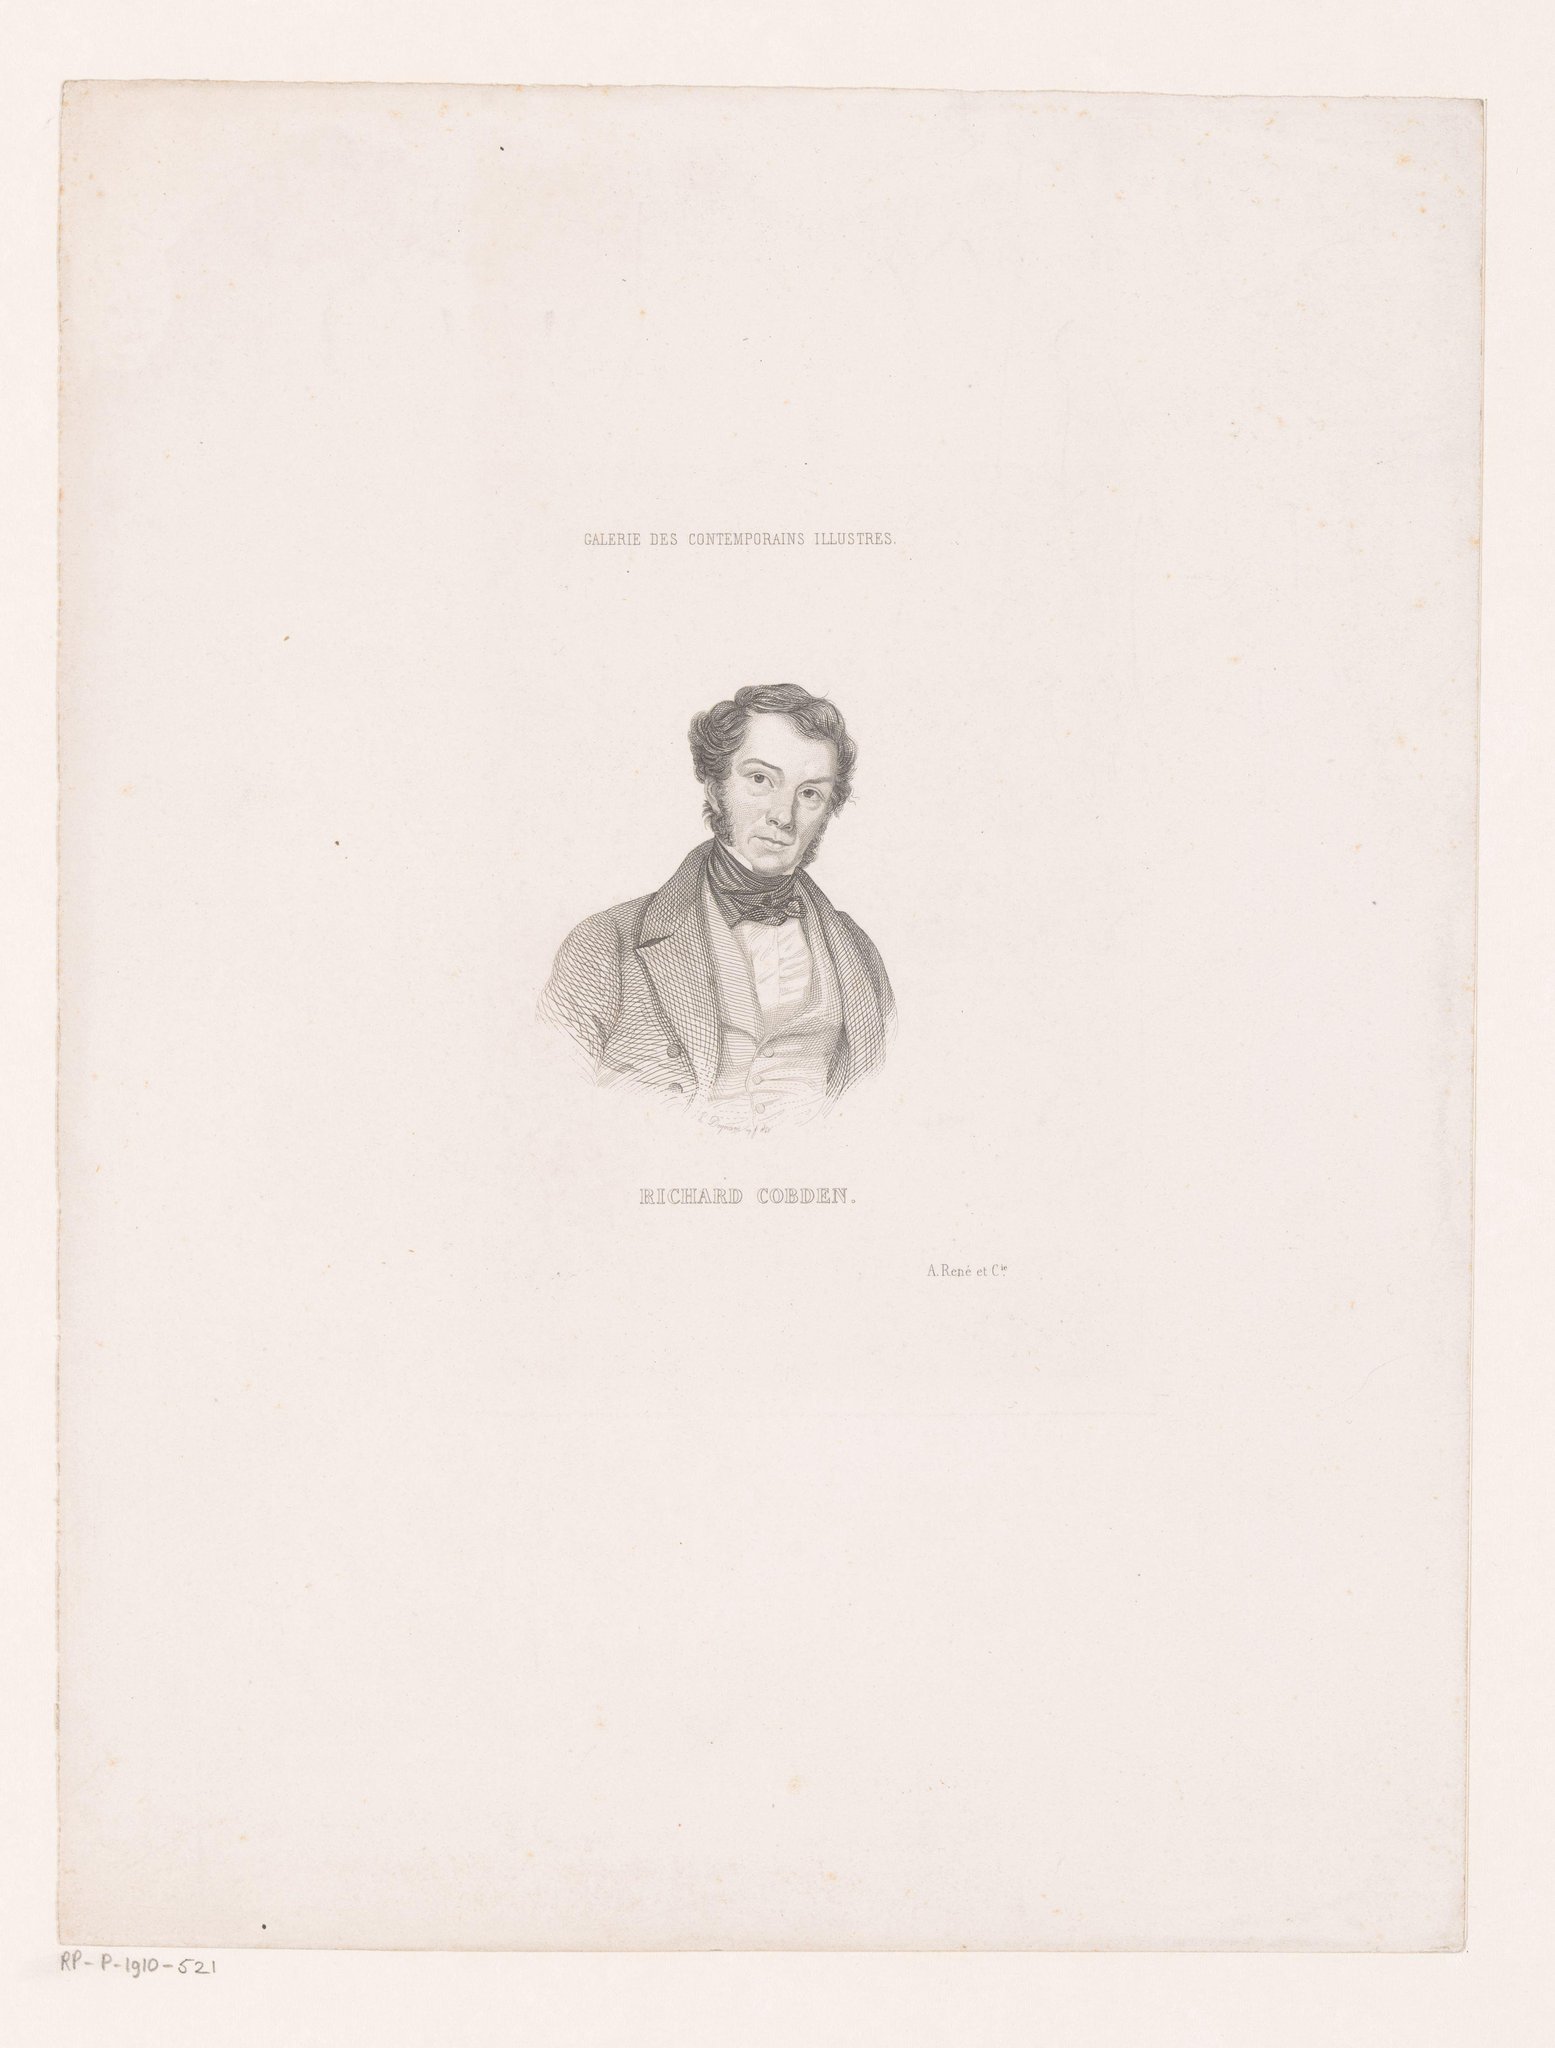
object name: print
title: Portret van Richard Cobden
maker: l. deymarie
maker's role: print maker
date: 1846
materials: paper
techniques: etching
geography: paris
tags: politician, manufacturer, historical persons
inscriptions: collector's mark: Lugt 2228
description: Prent uit: Loménie, Louis de. Galerie des contemporains illustres / par un homme de rien. Parijs: René, A. 1840-1847.